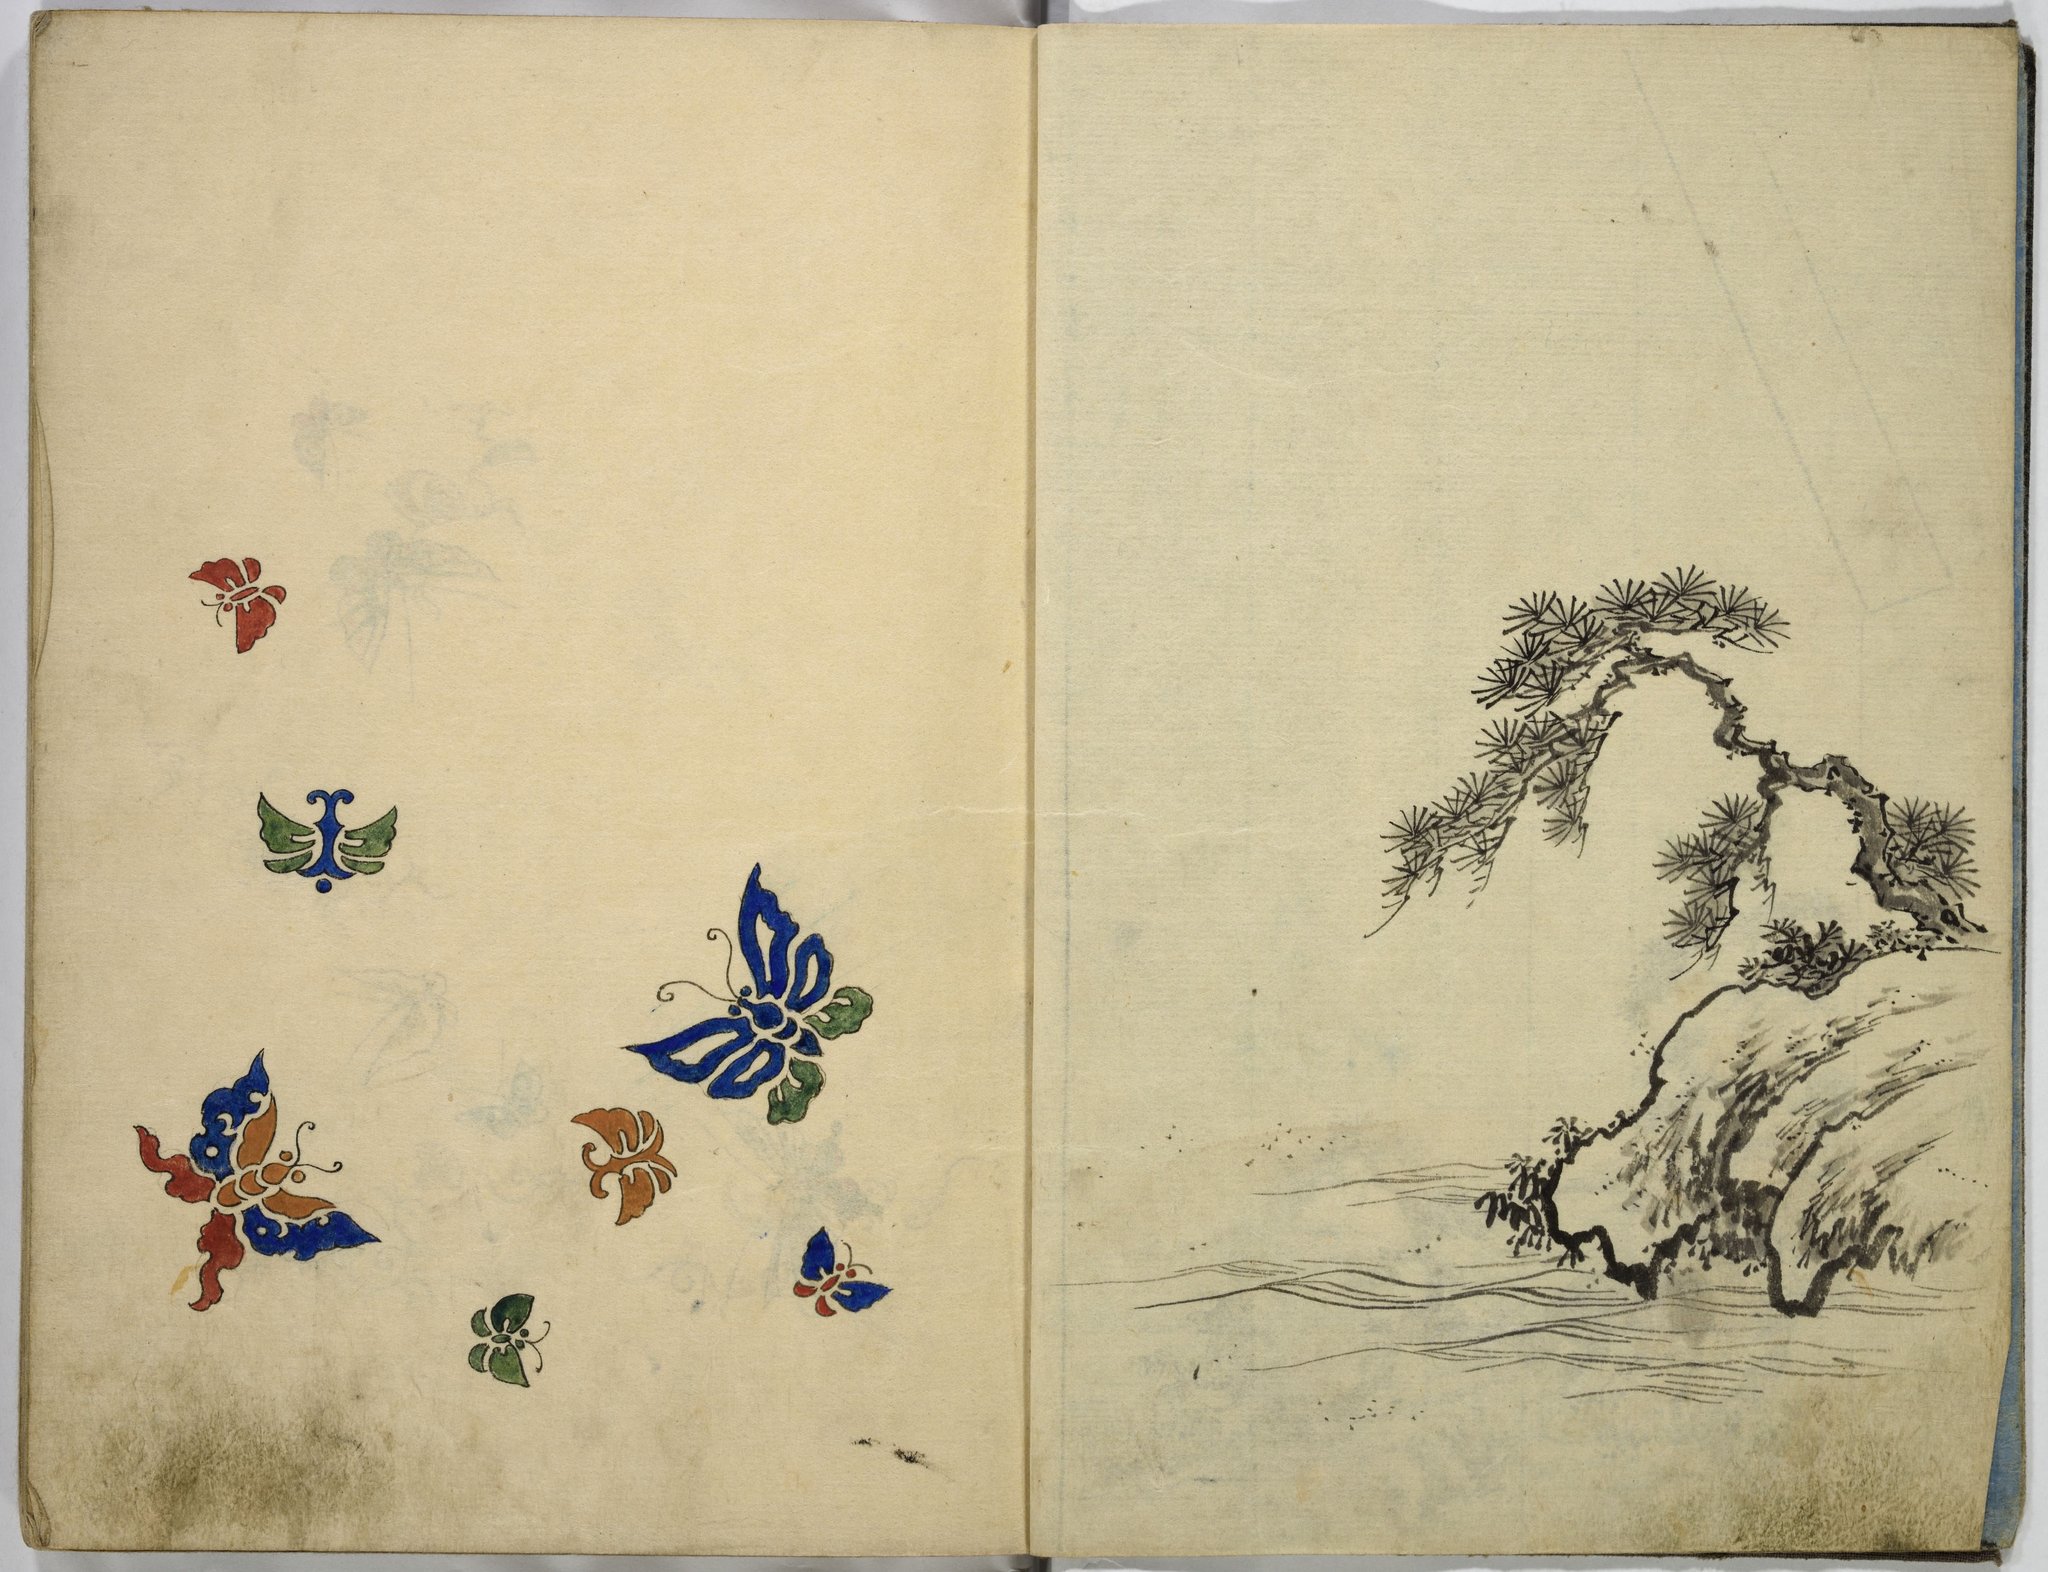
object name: illustrated book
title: Hinagata cho (Model Book)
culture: japanese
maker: unidentified artist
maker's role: artist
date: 1801-1900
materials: ink, paper, watercolor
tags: butterflies